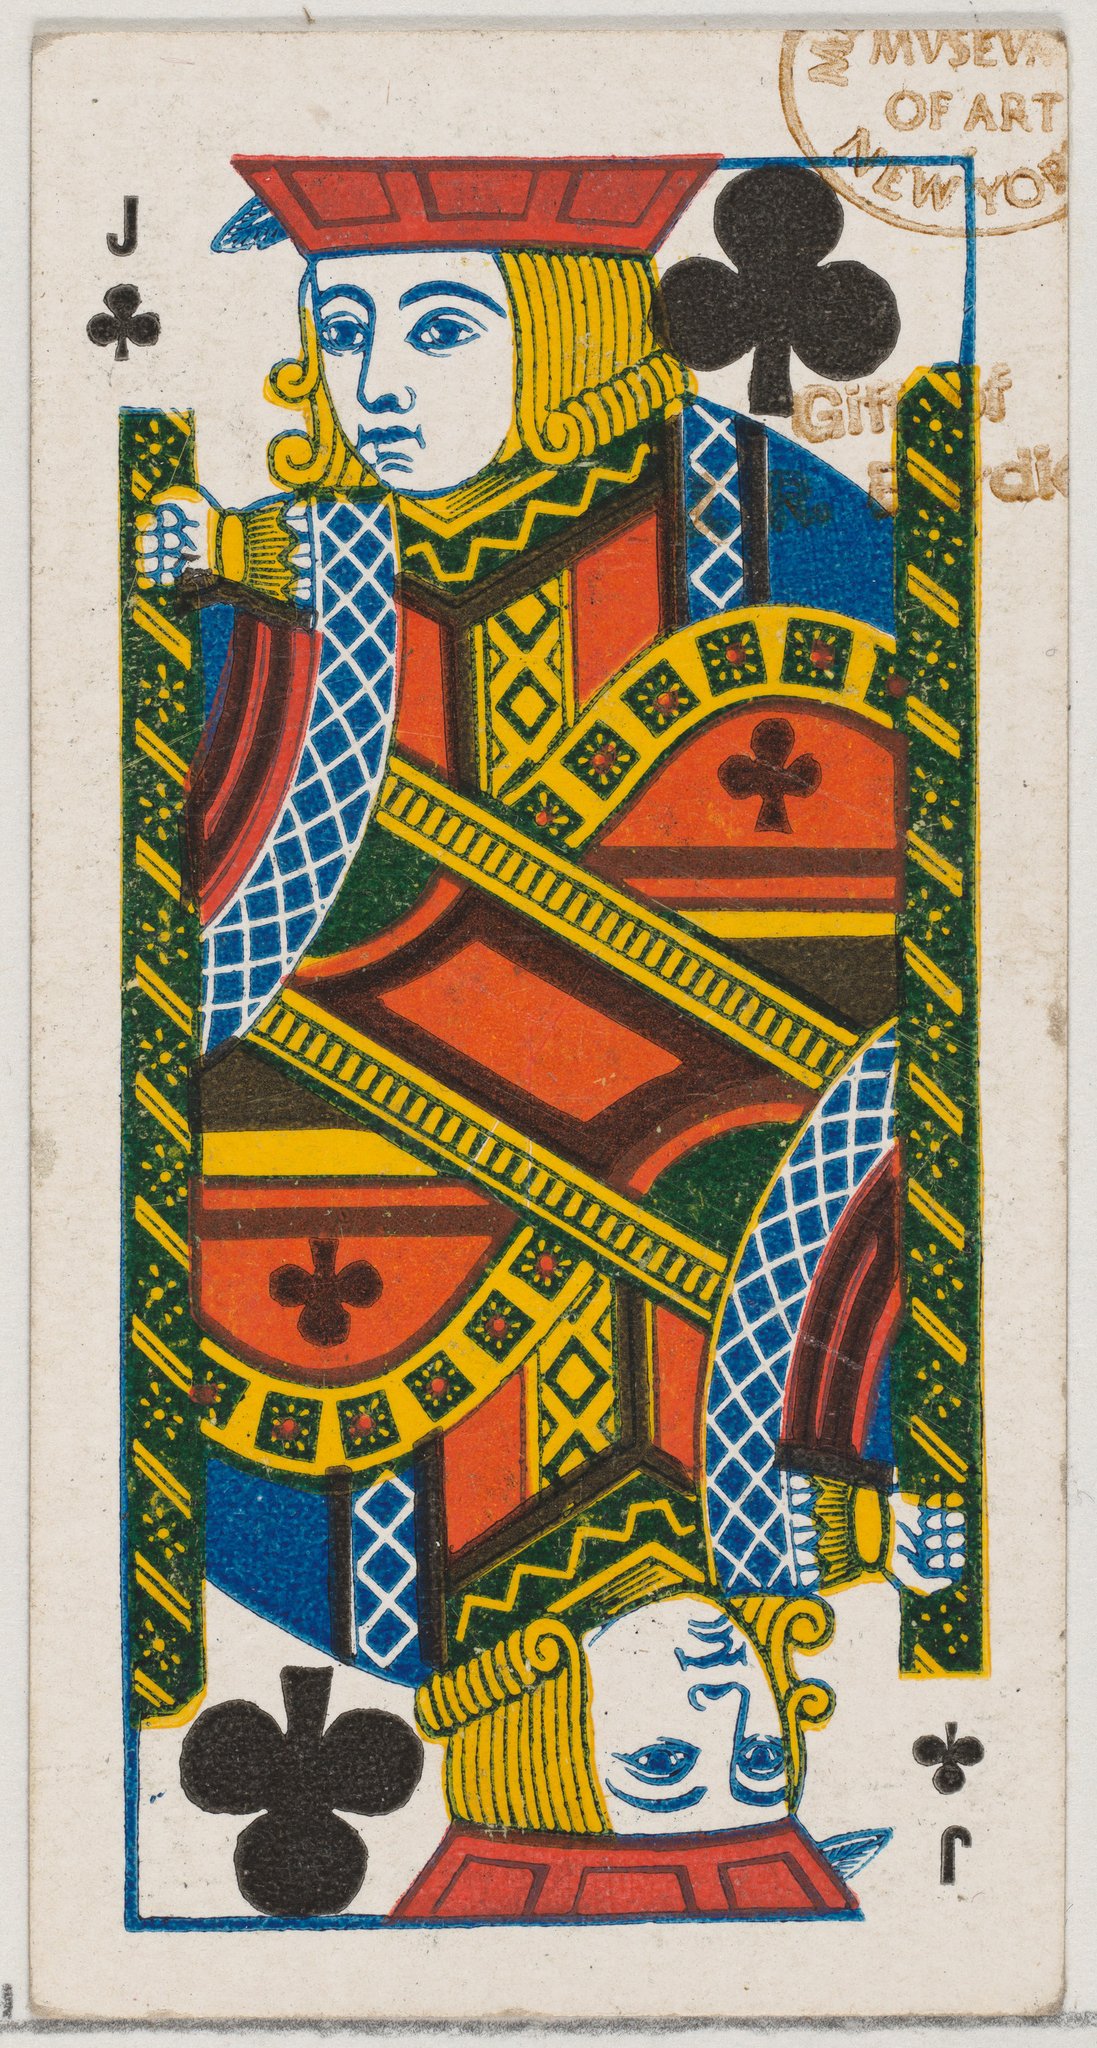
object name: print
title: Jack of Clubs (black), from the Playing Cards series (N84) for Duke brand cigarettes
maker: w. duke, sons & co.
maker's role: publisher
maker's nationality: american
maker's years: 1870-1920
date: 1888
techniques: color lithograph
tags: playing cards